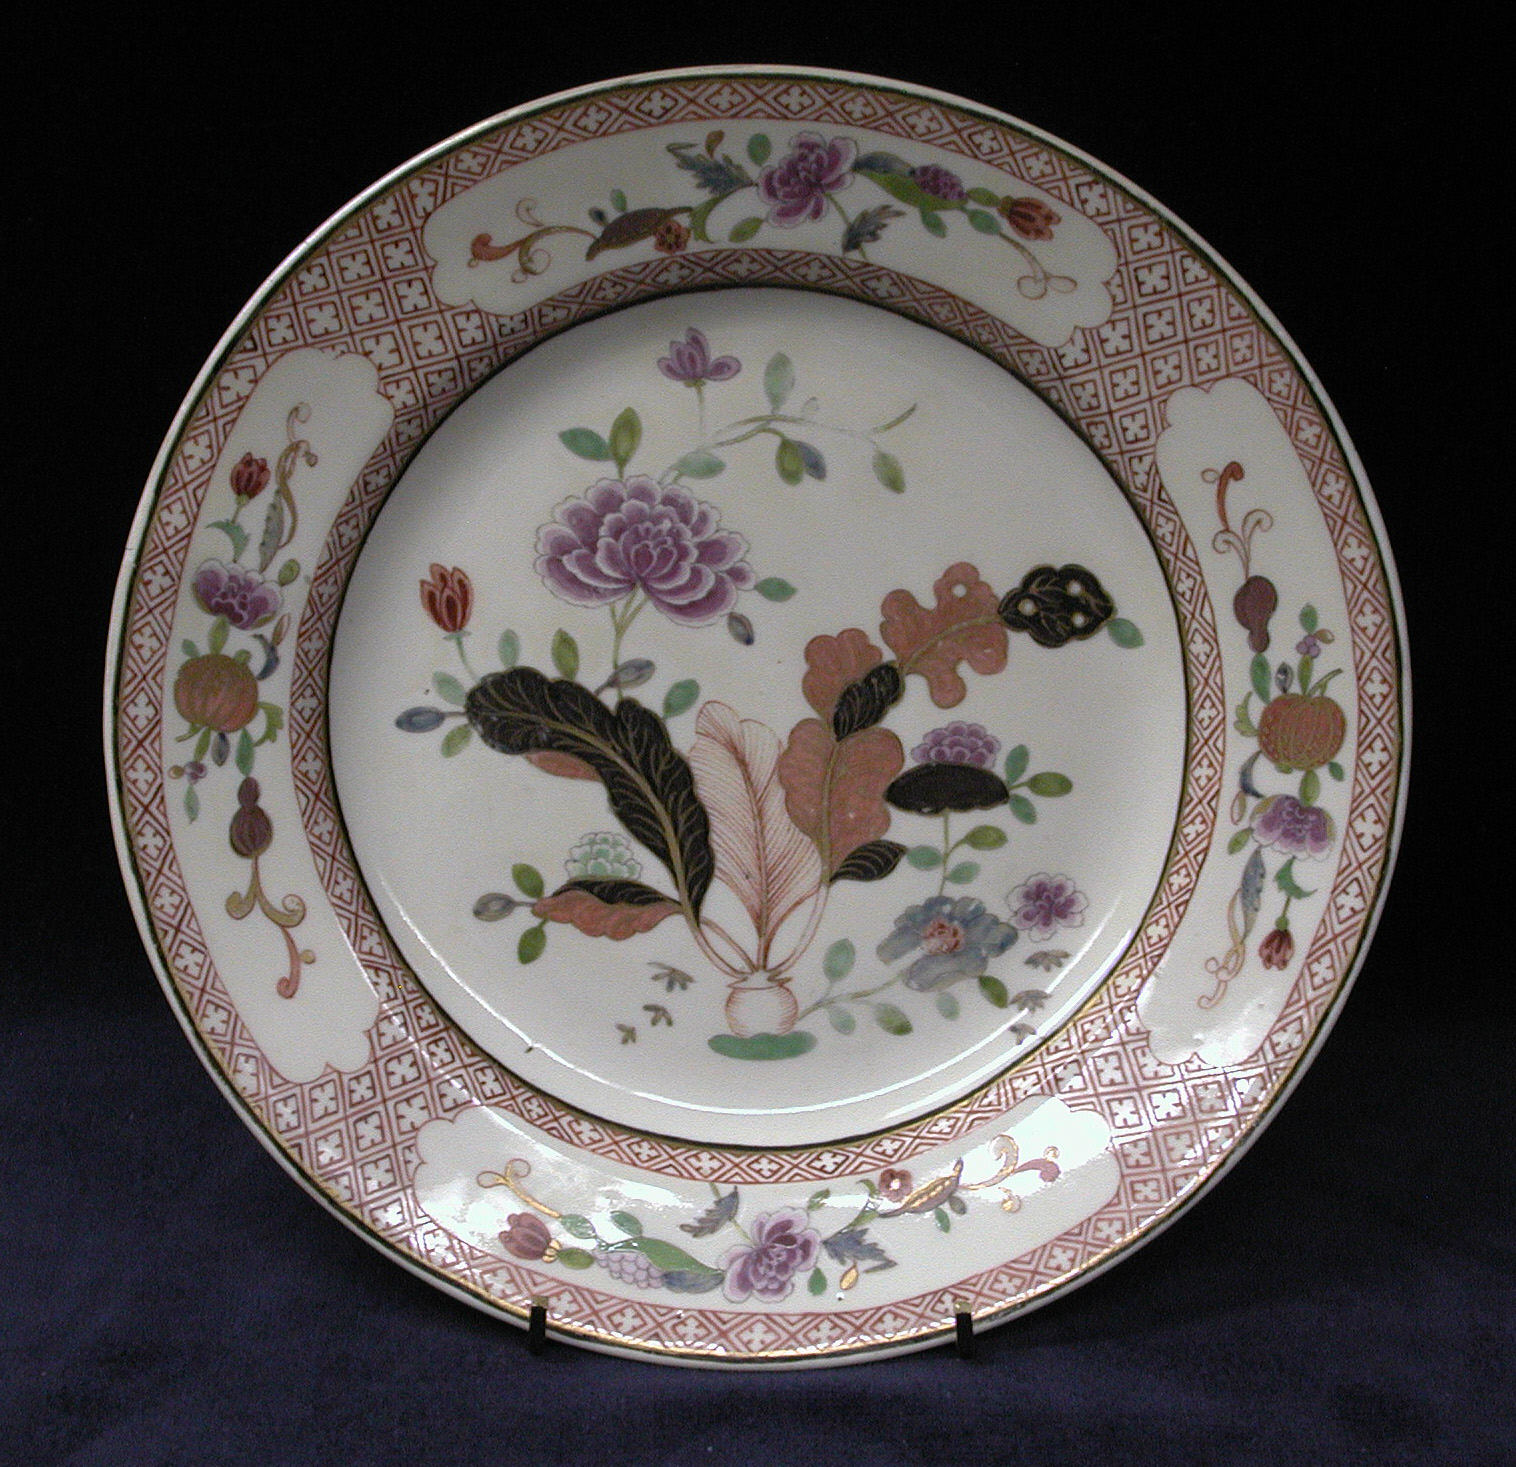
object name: plate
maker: imperial porcelain manufactory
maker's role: manufactory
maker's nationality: austrian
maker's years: 1744-1864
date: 1784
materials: hard paste porcelain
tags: flowers